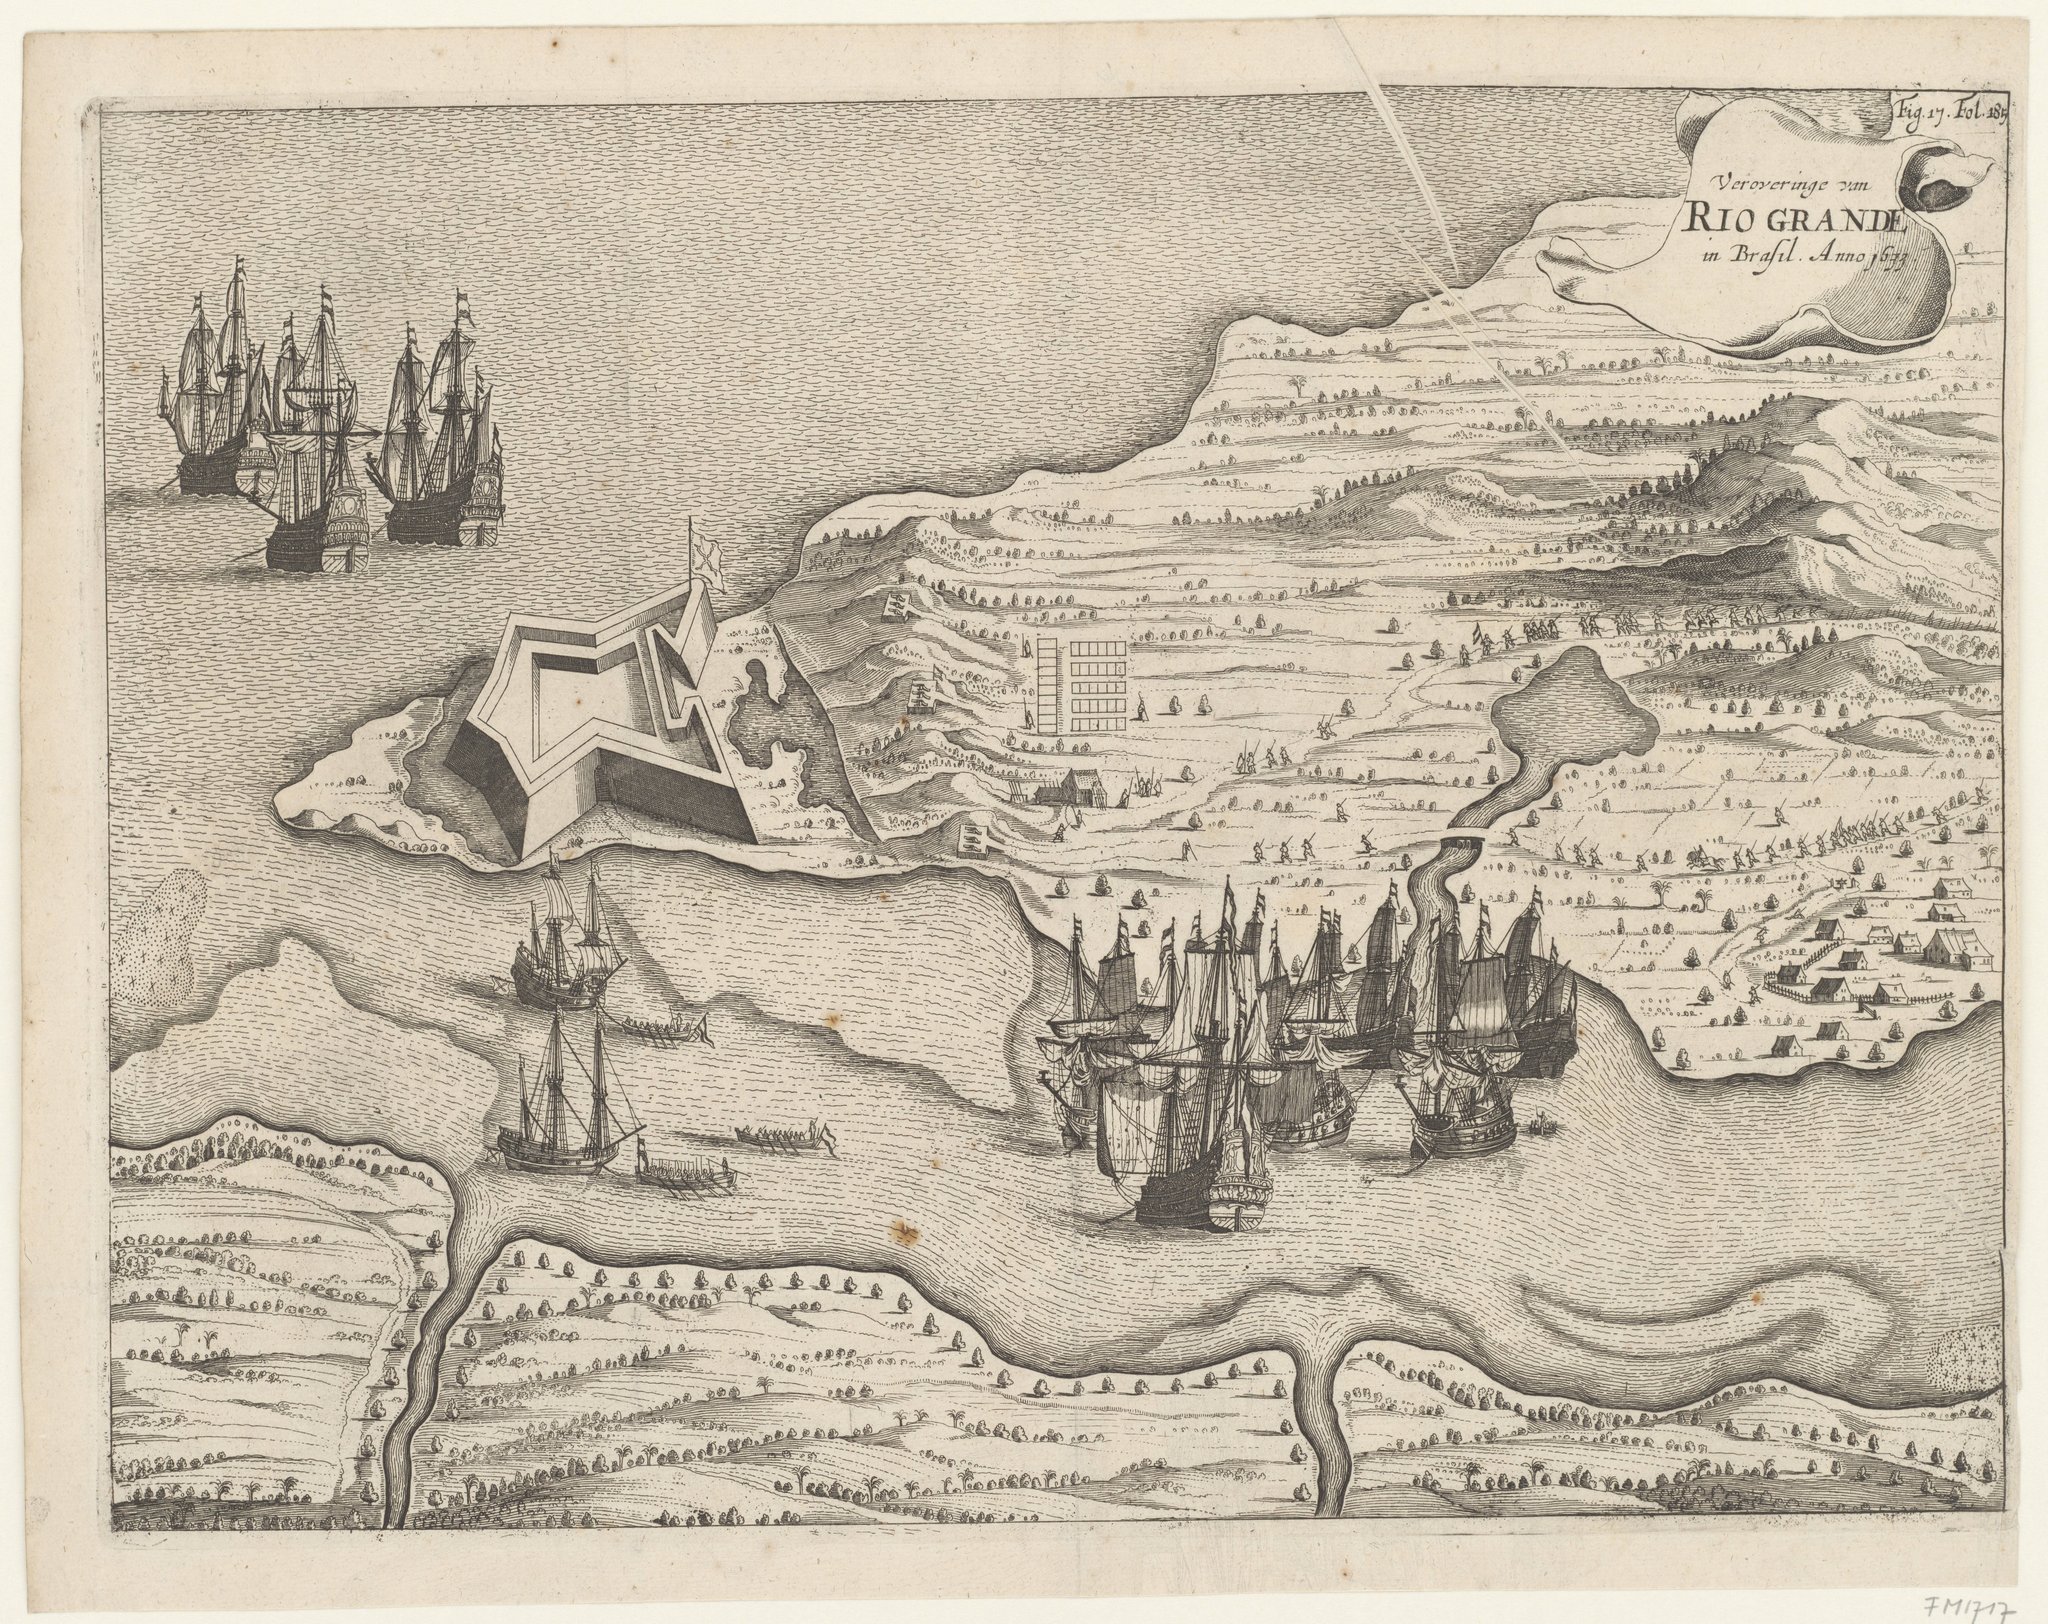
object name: history print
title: Veroveringe van Rio Grande in Brasil. Anno 1633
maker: Anonymous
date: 1649-1651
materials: paper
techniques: etching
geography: northern netherlands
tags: maps of separate countries or regions, capture of city (after the siege), brasil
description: Verovering van Rio Grande in Brazilië, december 1633. Plan van de Braziliaanse kust met een kasteel aan de monding van de rivier Rio Grande. De naam van het kasteel Tres Reyes werd na verovering veranderd in Keulen. Voor de kust en in de rivier liggen Nederlandse schepen voor anker. Gemerkt rechtsboven: Fig. 17. Fol. 185.